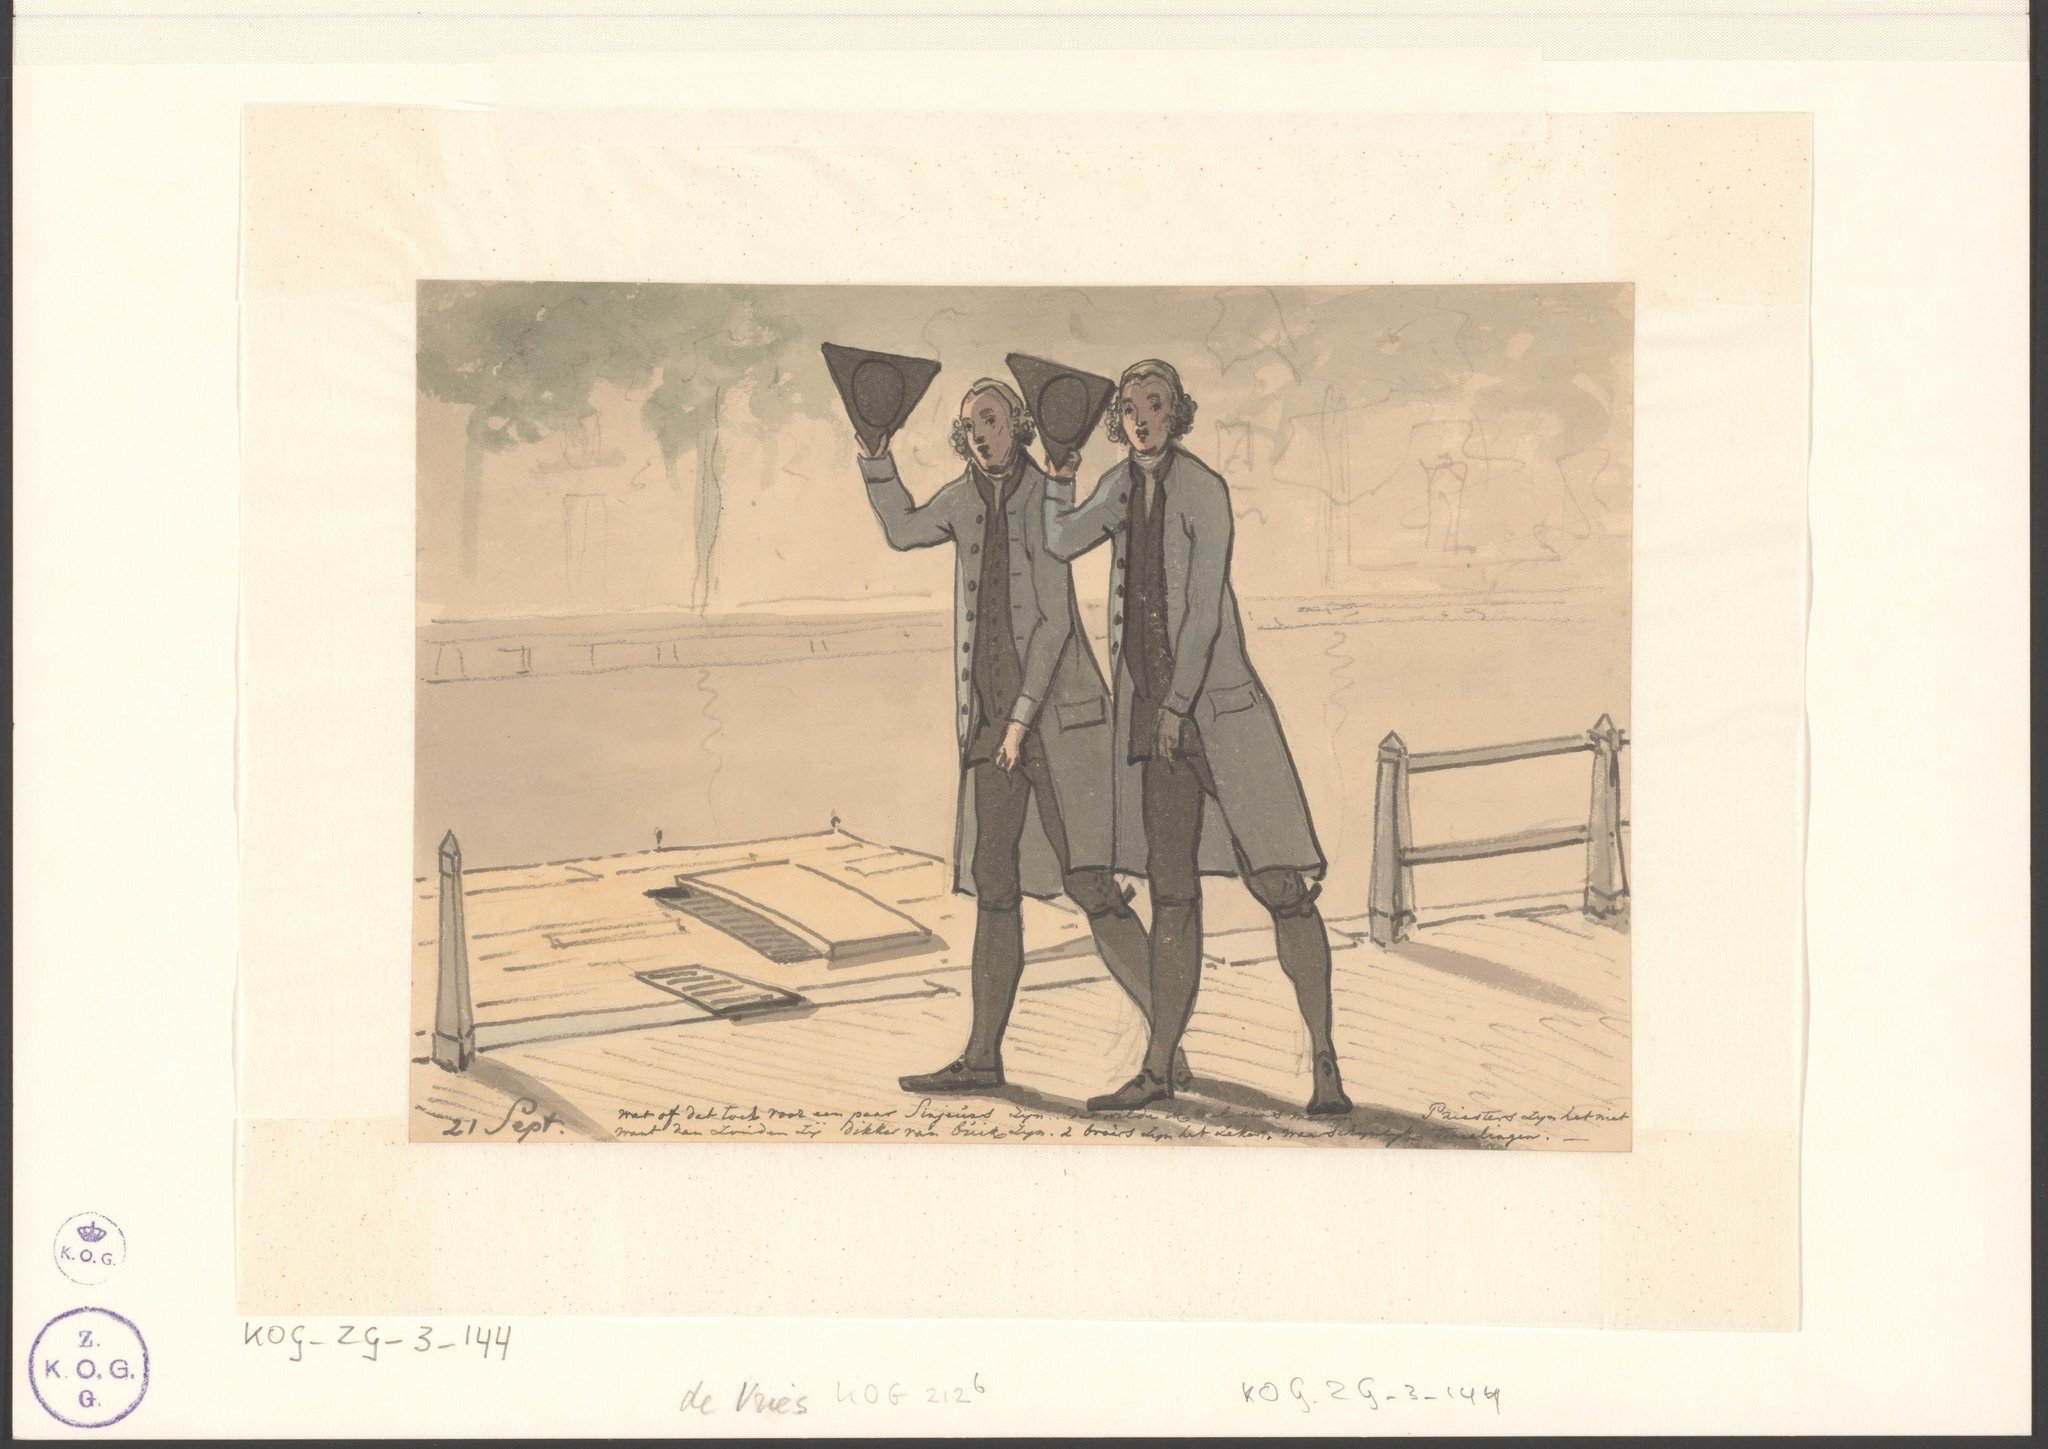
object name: drawing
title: Twee mannen met een driekantige steek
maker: christiaan andriessen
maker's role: draughtsman, print maker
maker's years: 1775-1846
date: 1805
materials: ink, paper, pencil, watercolor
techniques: brush, pen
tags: standing figure, head-gear: tricorn, canal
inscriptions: signature: ‘J Andriessen’, inscription: ‘21 Sept. wat of dat toch voor een paar sinjeurs zijn (...)’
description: Dagboekblad uit het getekende dagboek dat Christiaan Andriessen bijhield van 1805 tot en met 1808.